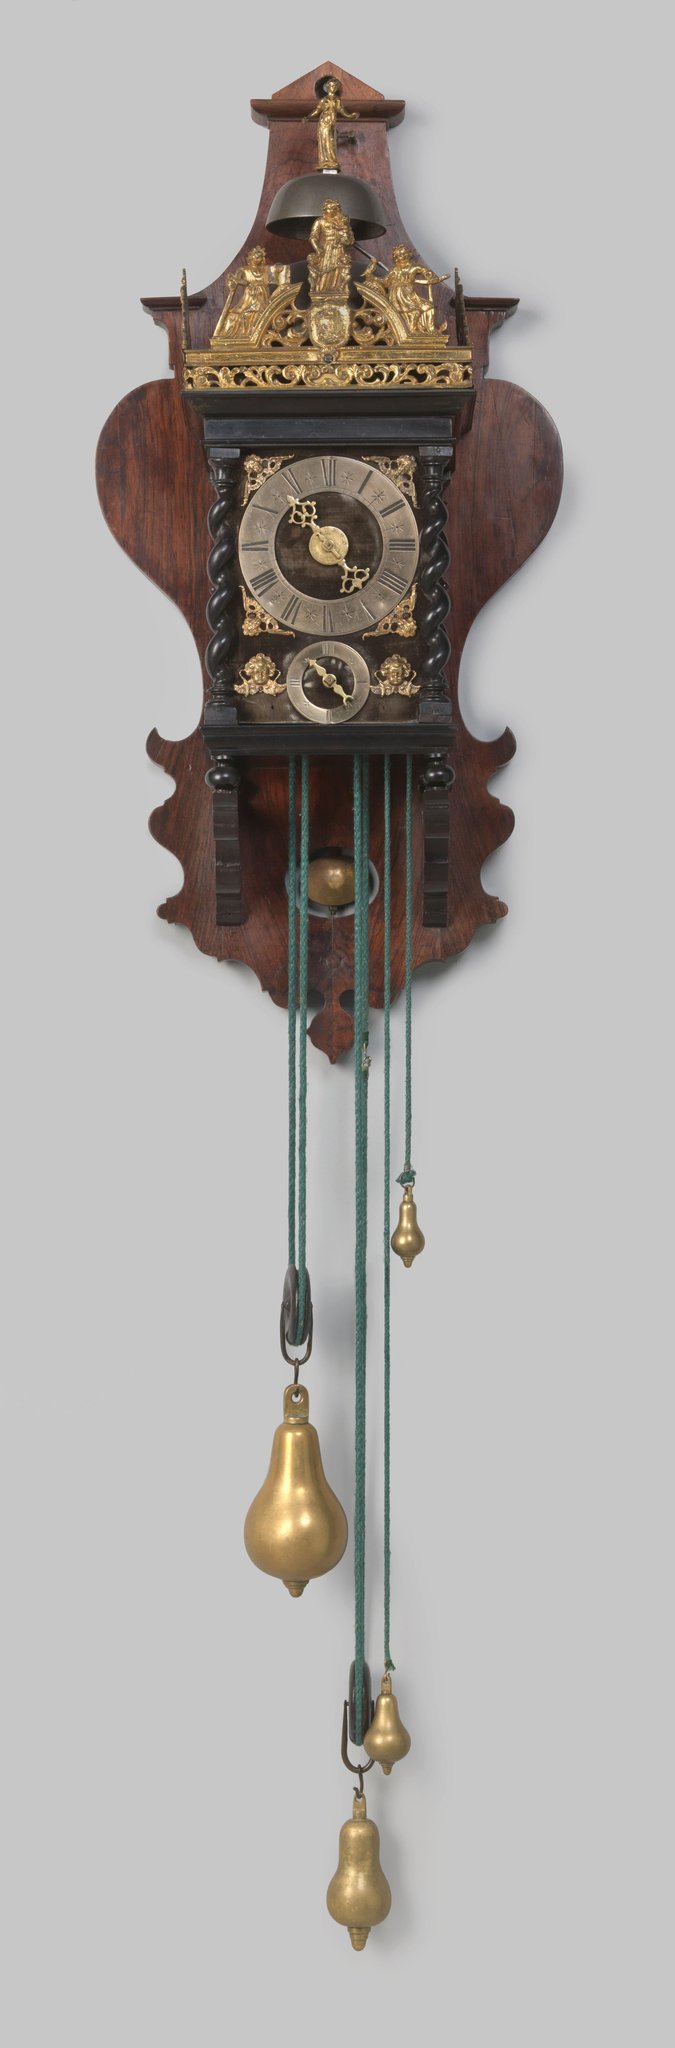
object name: mechanical clock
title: Hangklok met geprofileerde voet- en kroonlijst en geslingerde hoekstijlen, op vaasvormige blad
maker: dirk engel (uurwerkmaker)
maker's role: clockmaker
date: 1700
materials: brass, glass, iron, lead, wood, velvet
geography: westzaan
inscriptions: signature: ‘D. Engel, Westzaan’, inscription: ‘Nu elck zijn sin’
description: Hollandse hangklok.Zwart hout, koperen ornamenten. Bekroning voorstellende geloof, hoop en liefde en het opschrift "Nu elck zijn sin". Aan de zijdes het wapen van de stad Amsterdam. De naam ven de uurwerkmaker is: D. Engel van Westzanen.